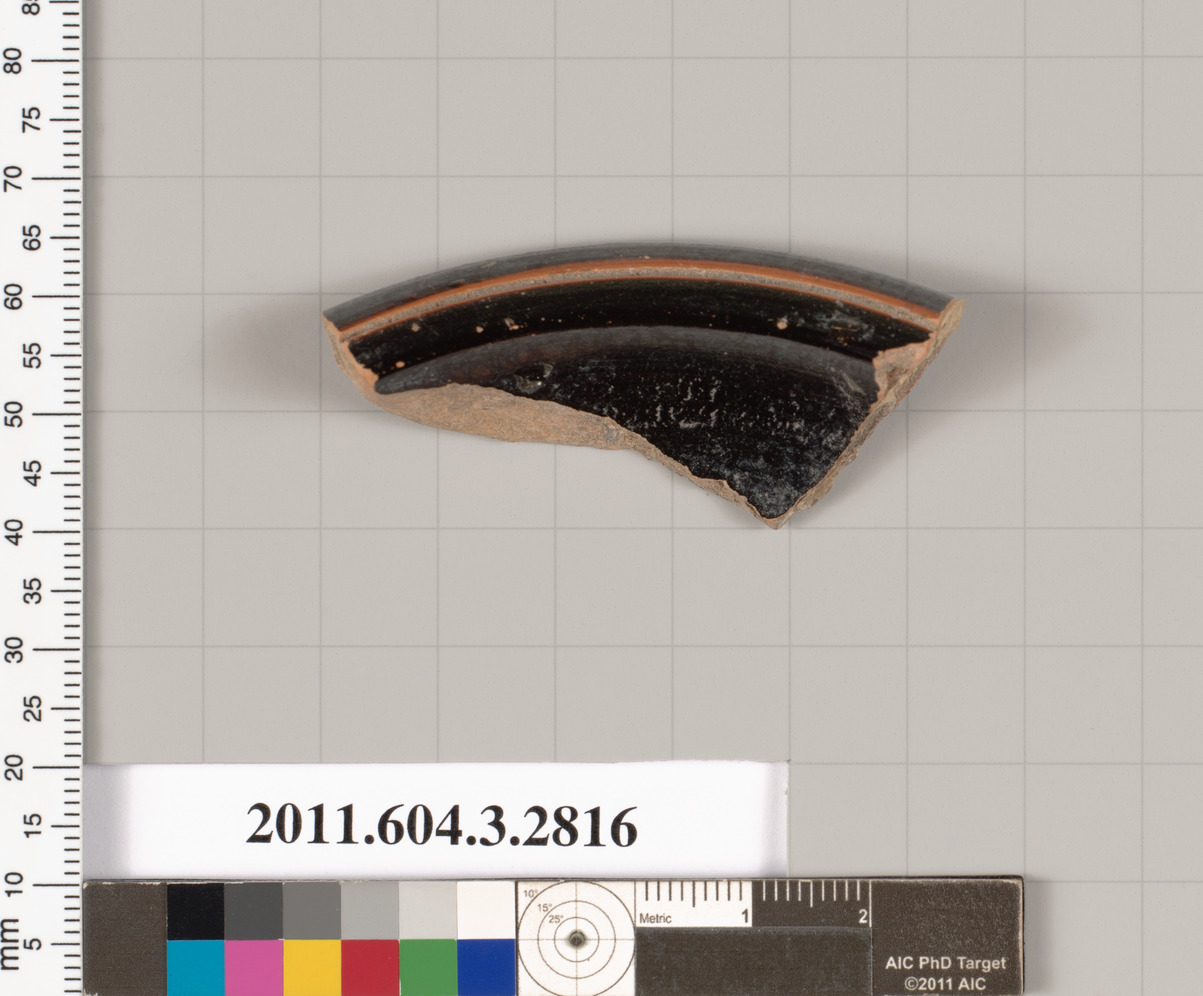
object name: fragment of a dish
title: Terracotta fragment of a dish?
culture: greek, attic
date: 550-501 BCE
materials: terracotta